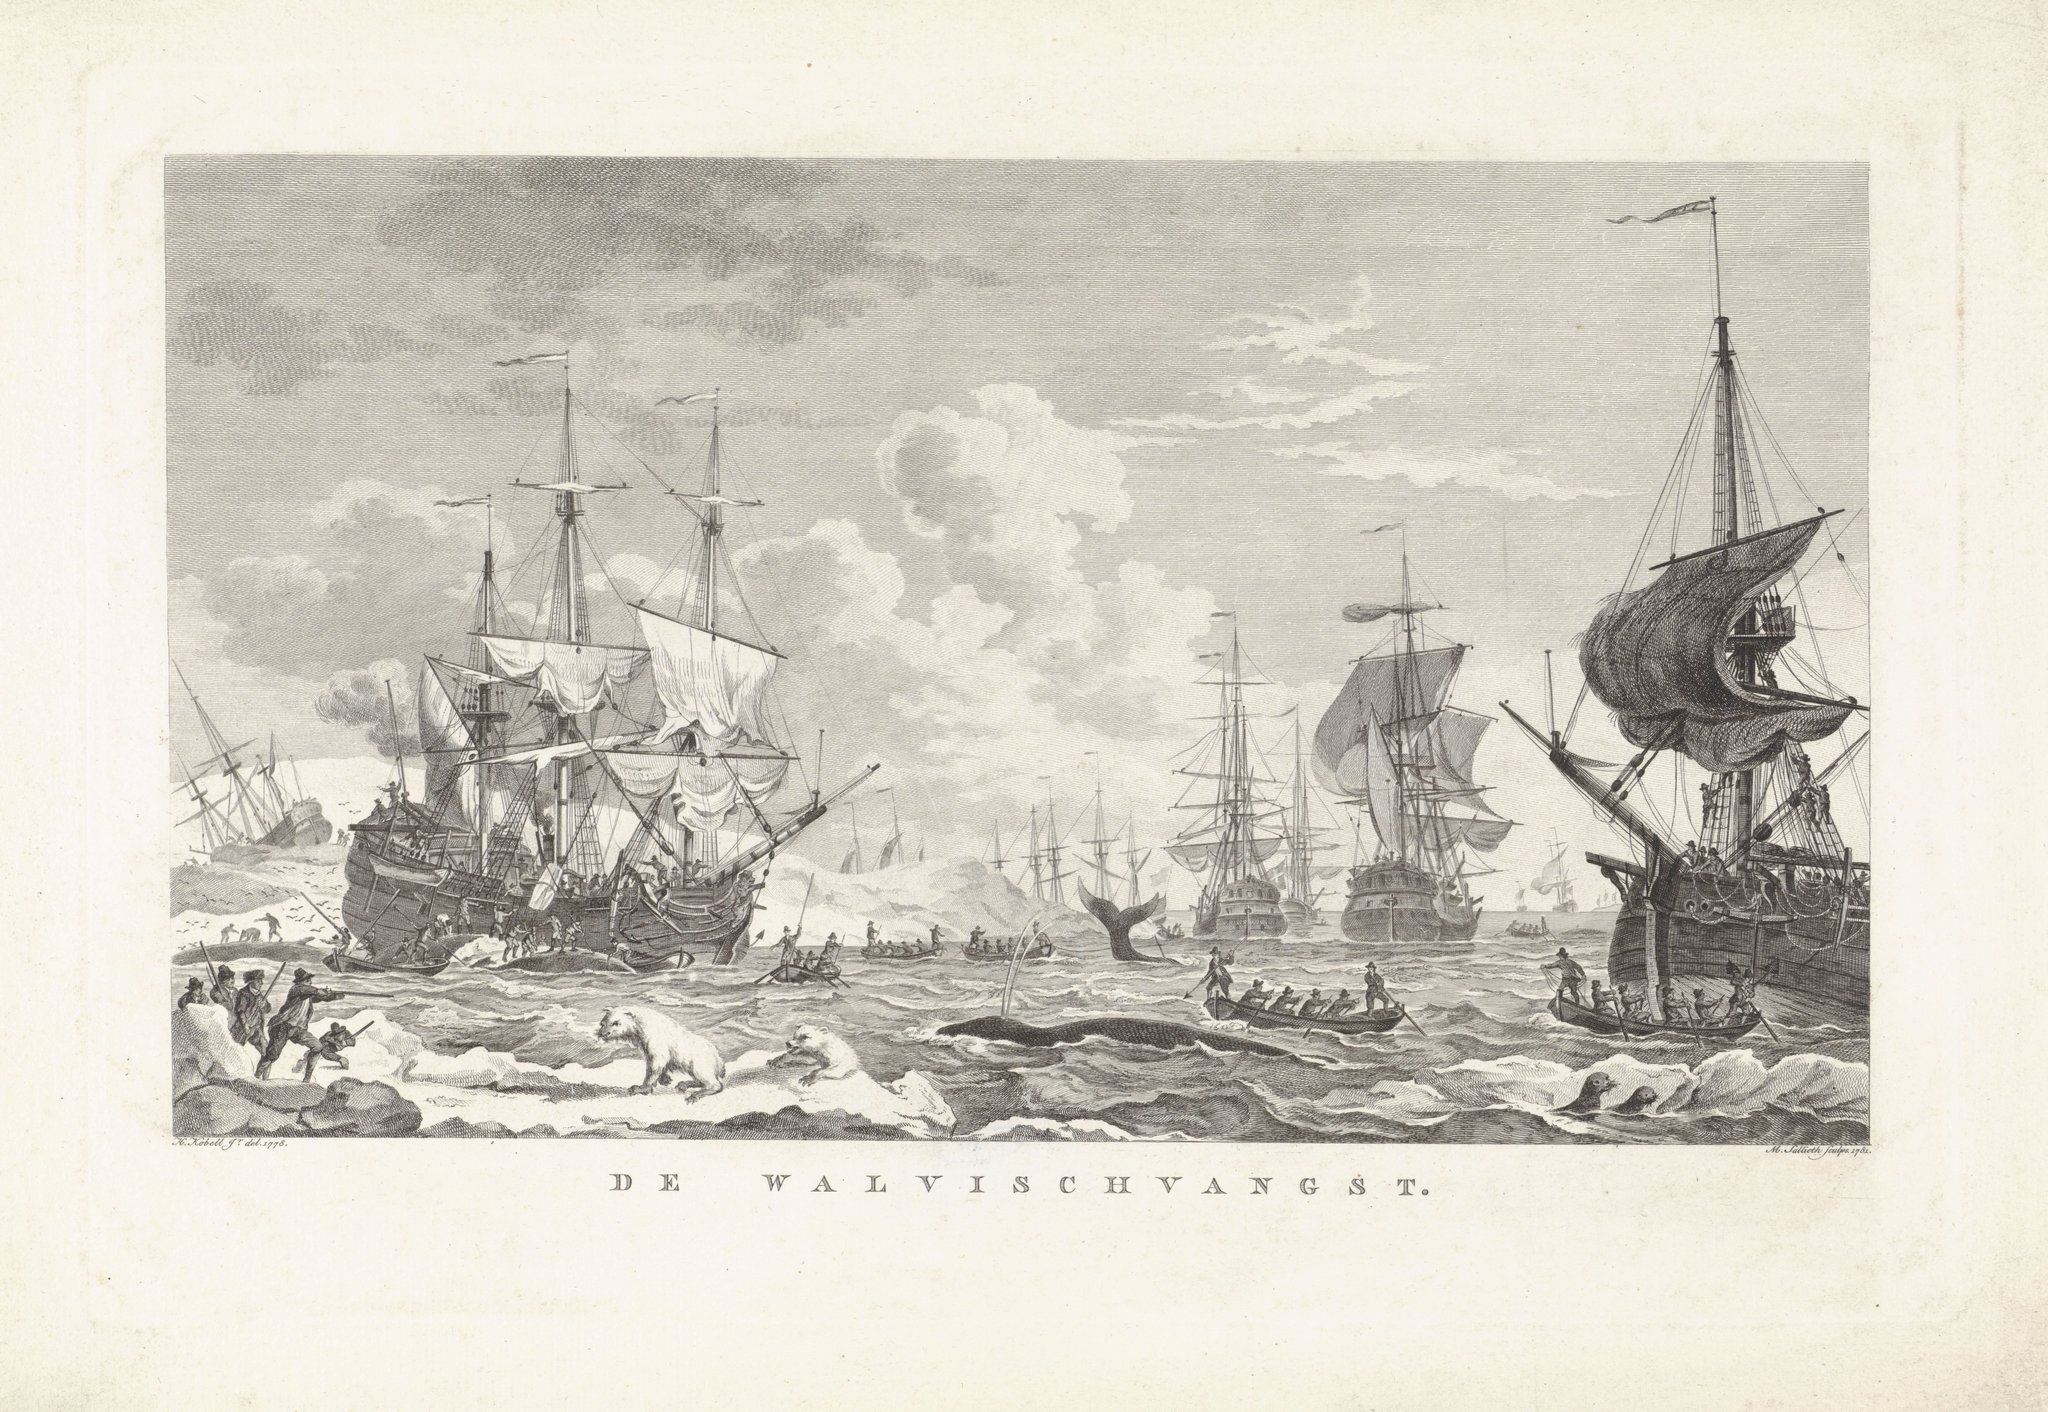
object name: print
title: Walvisvangst, 1781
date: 1781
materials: paper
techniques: engraving, etching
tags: beasts of prey, predatory animals: polar bear, whale fishery, whaling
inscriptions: collector's mark: Lugt 2228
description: Het jagen op walvissen in de Noordelijke IJszee, 1781. Op de voorgrond schieten jagers op ijsberen.